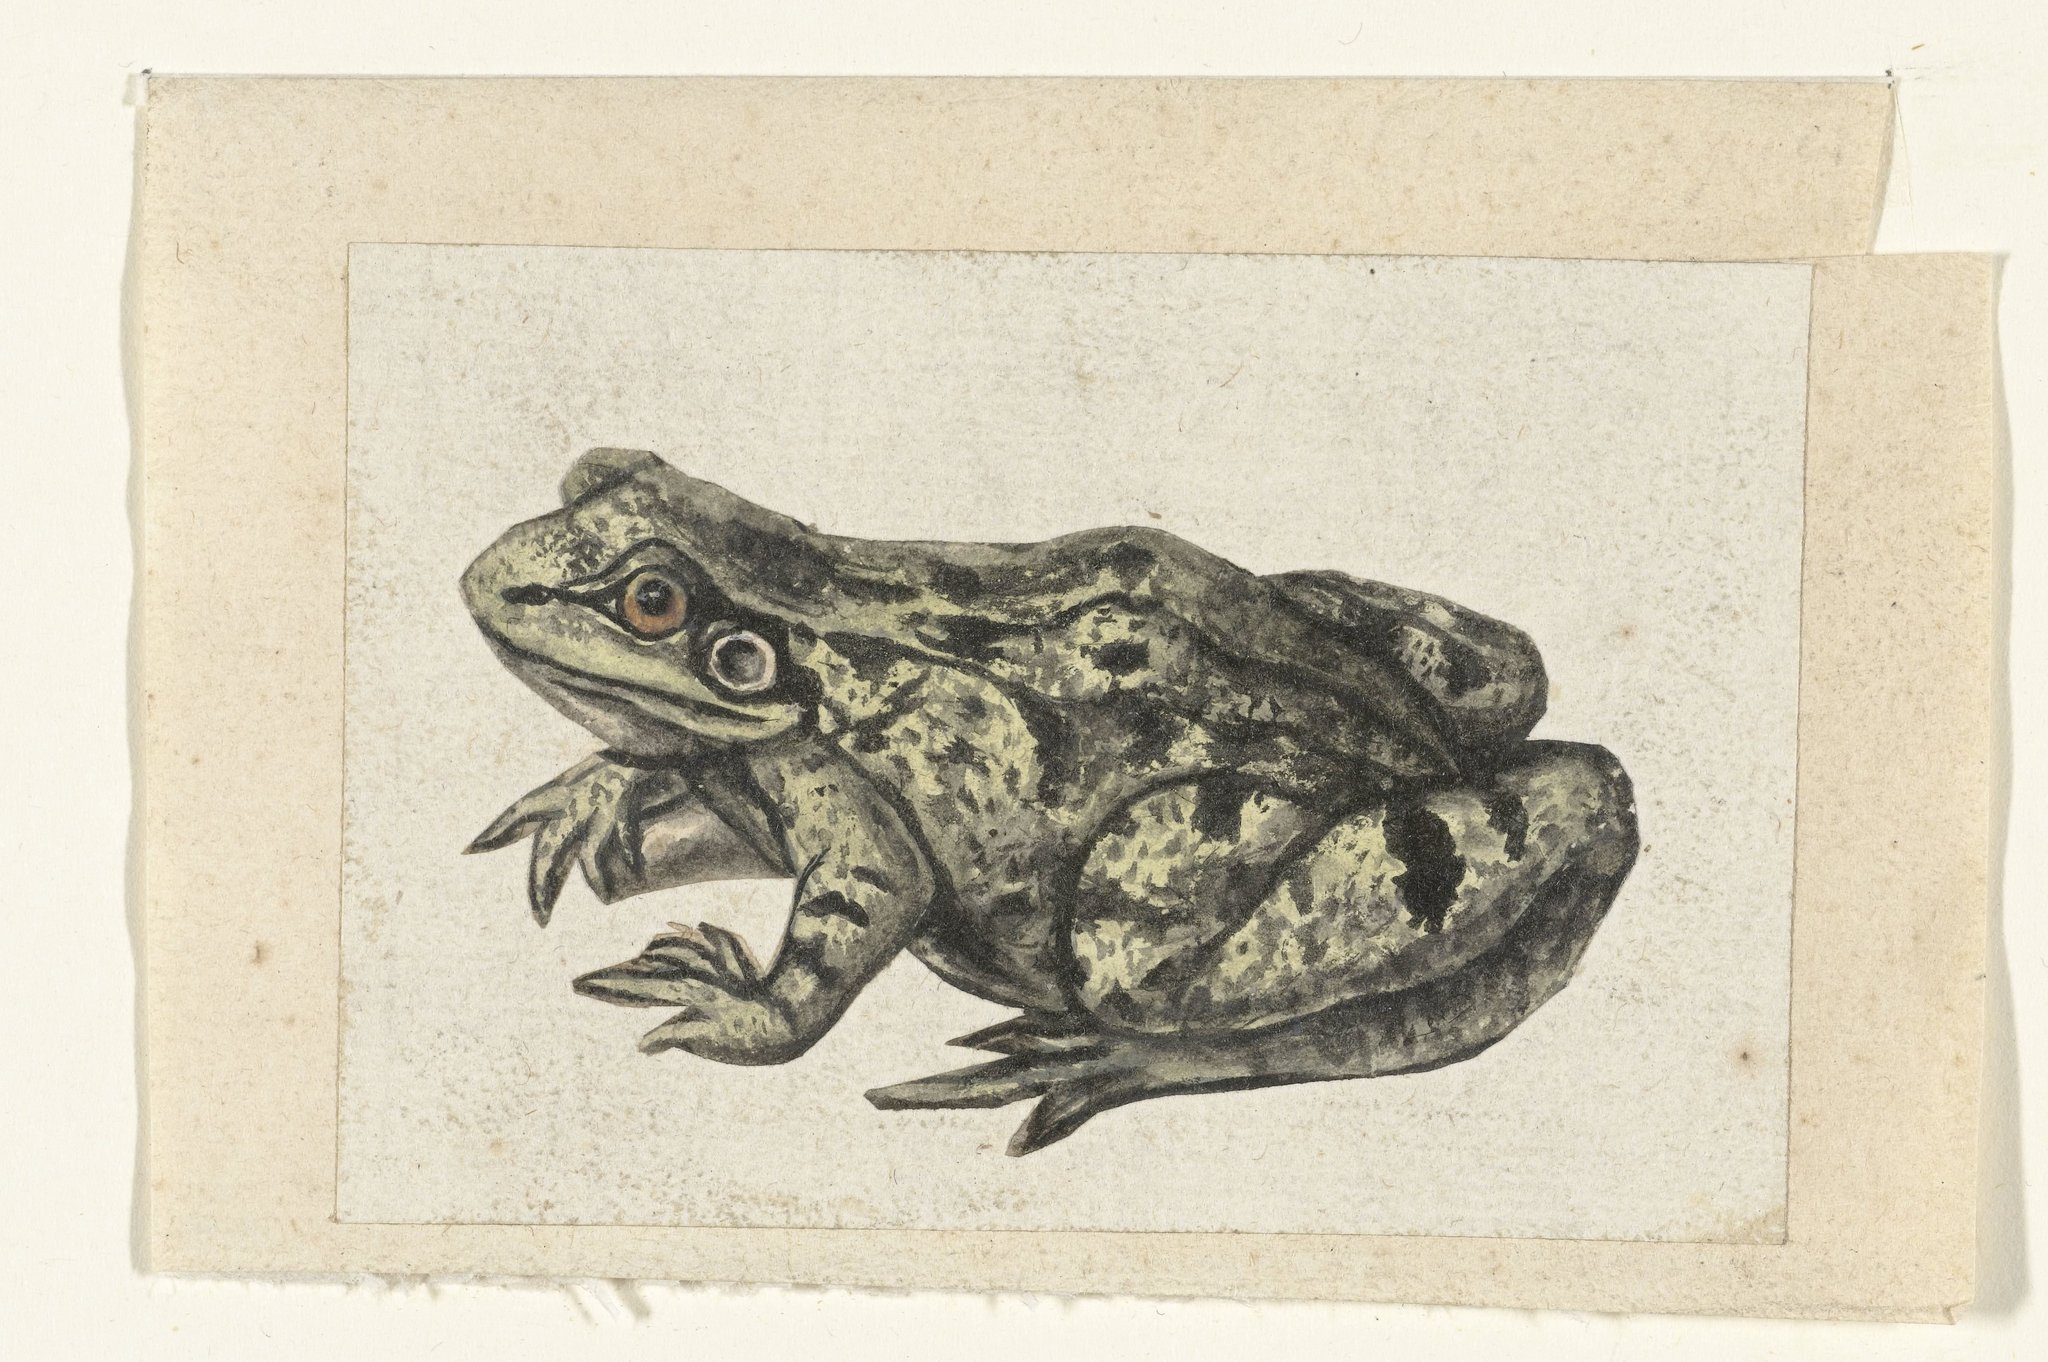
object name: drawing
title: Lombard album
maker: Anonymous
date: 1560-1585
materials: paper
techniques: brush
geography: low countries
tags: tailless amphibians: frog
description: Blad uit album van 100 (?) bladen met tekeningen van dieren.